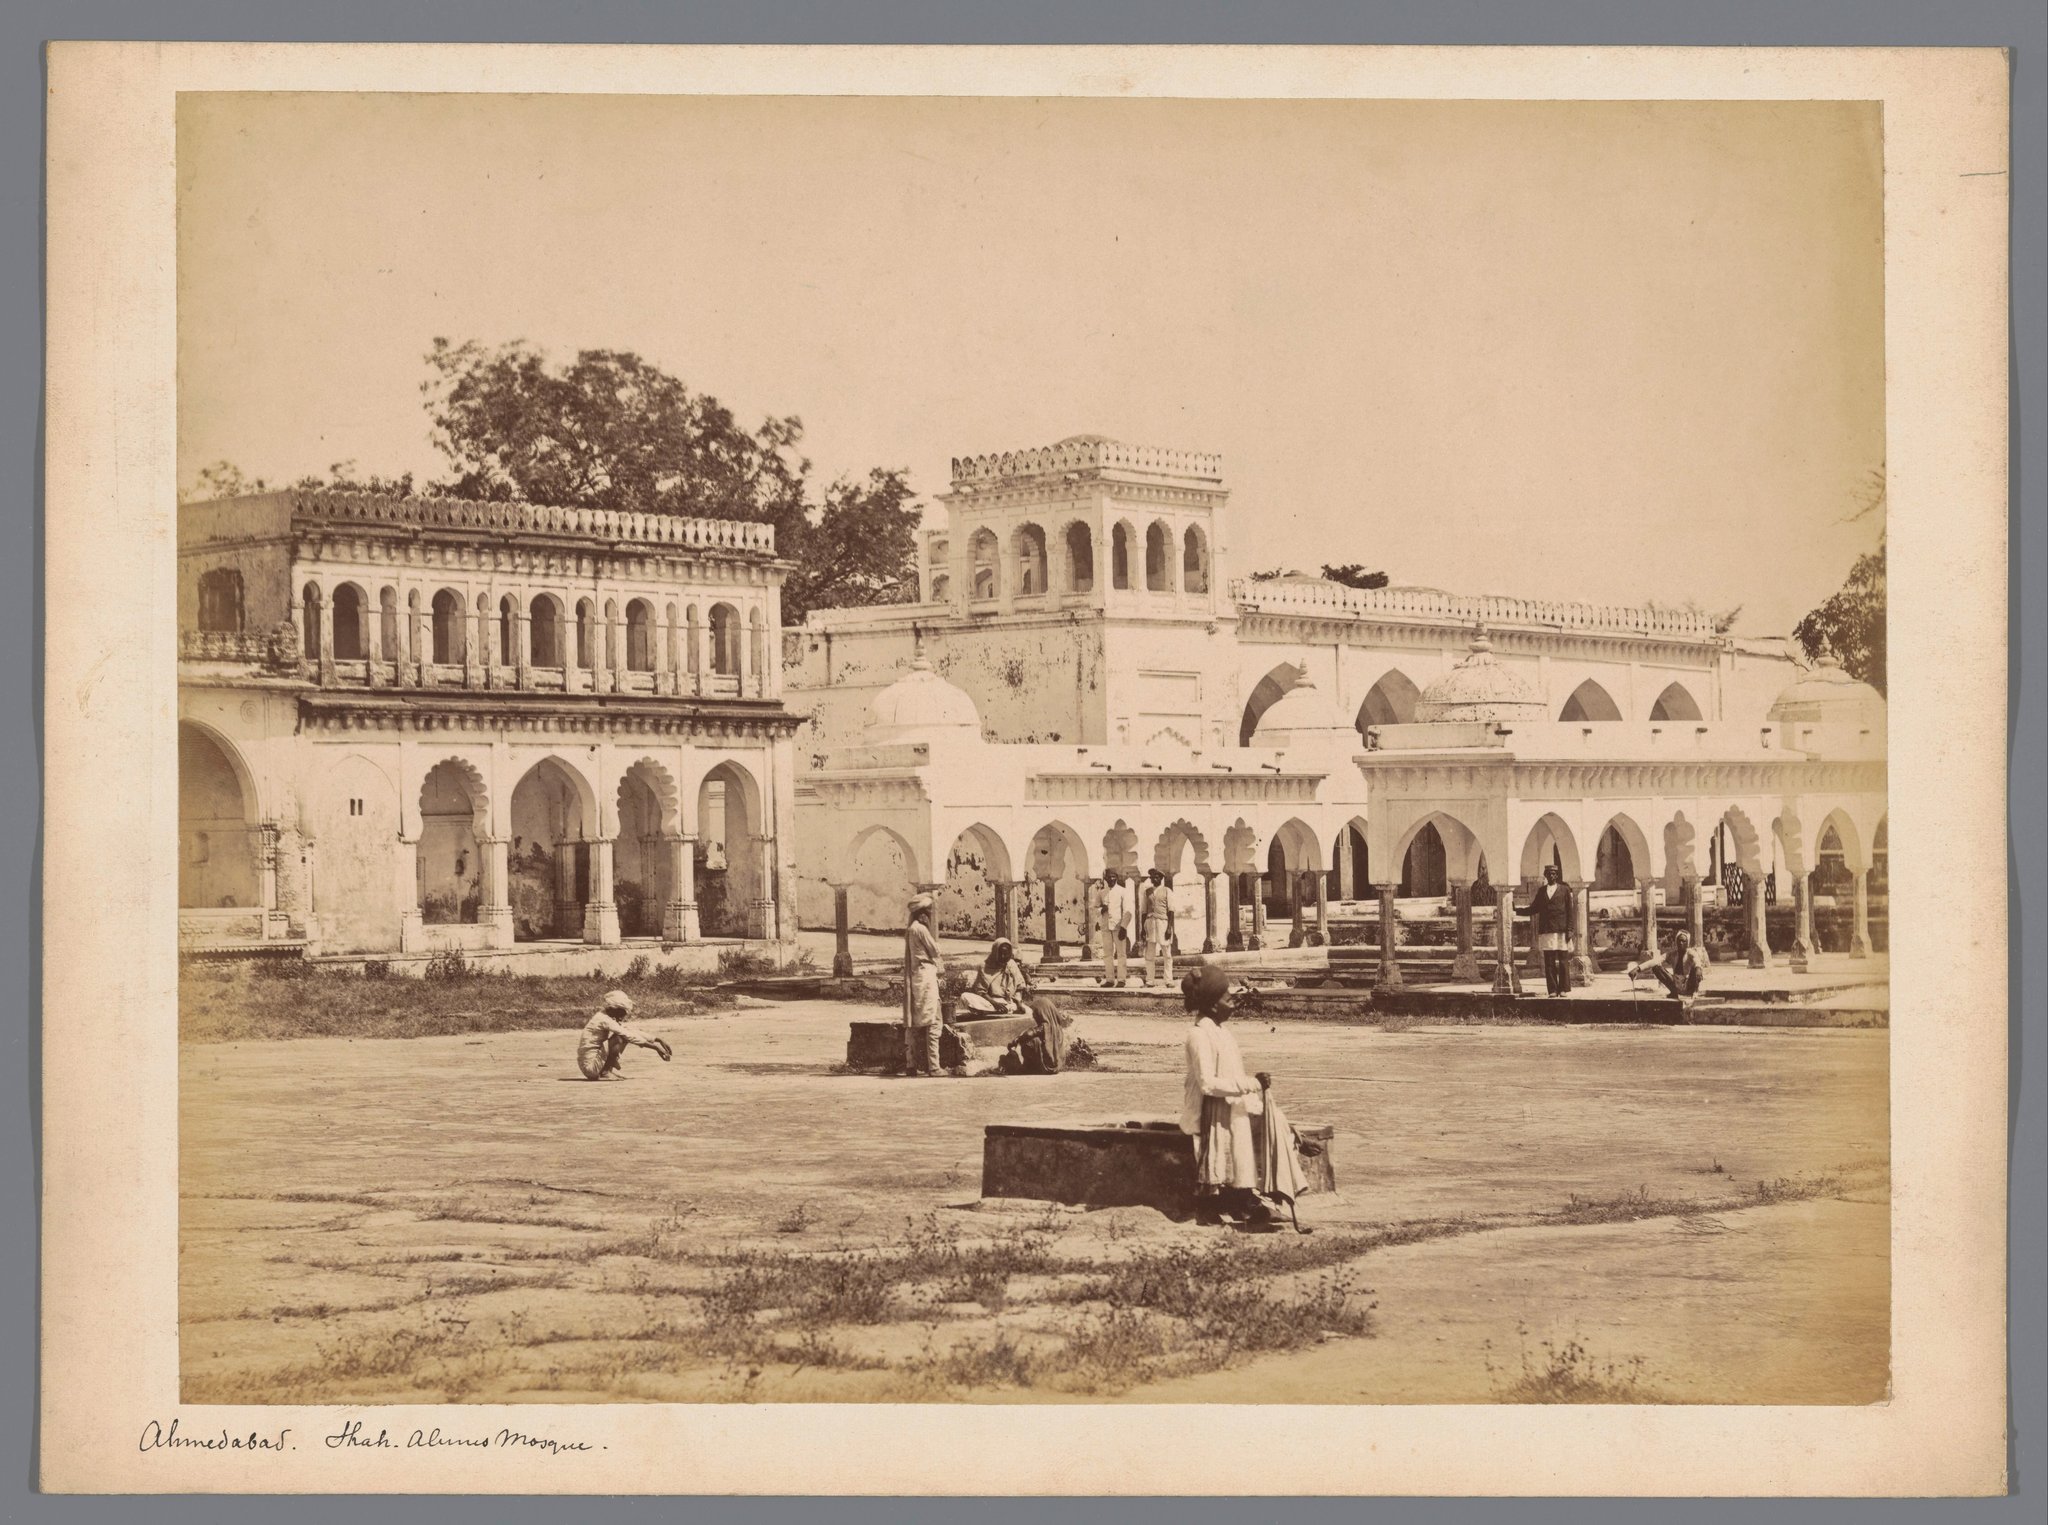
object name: photograph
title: Courtyard of Shah-e-Alam's Roza in Ahmedebad, Gujarat, India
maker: Anonymous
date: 1865-1890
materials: cardboard, paper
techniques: albumen print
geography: ahmedabad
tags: temple, shrine ~ islam, mohammedanism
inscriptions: title: ‘Ahmedabad. Shah-Alums Mosque.’, number: ‘11’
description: Shah-e-Alam Roza is een middeleeuws moskee- en grafcomplex in Ahmedabad.